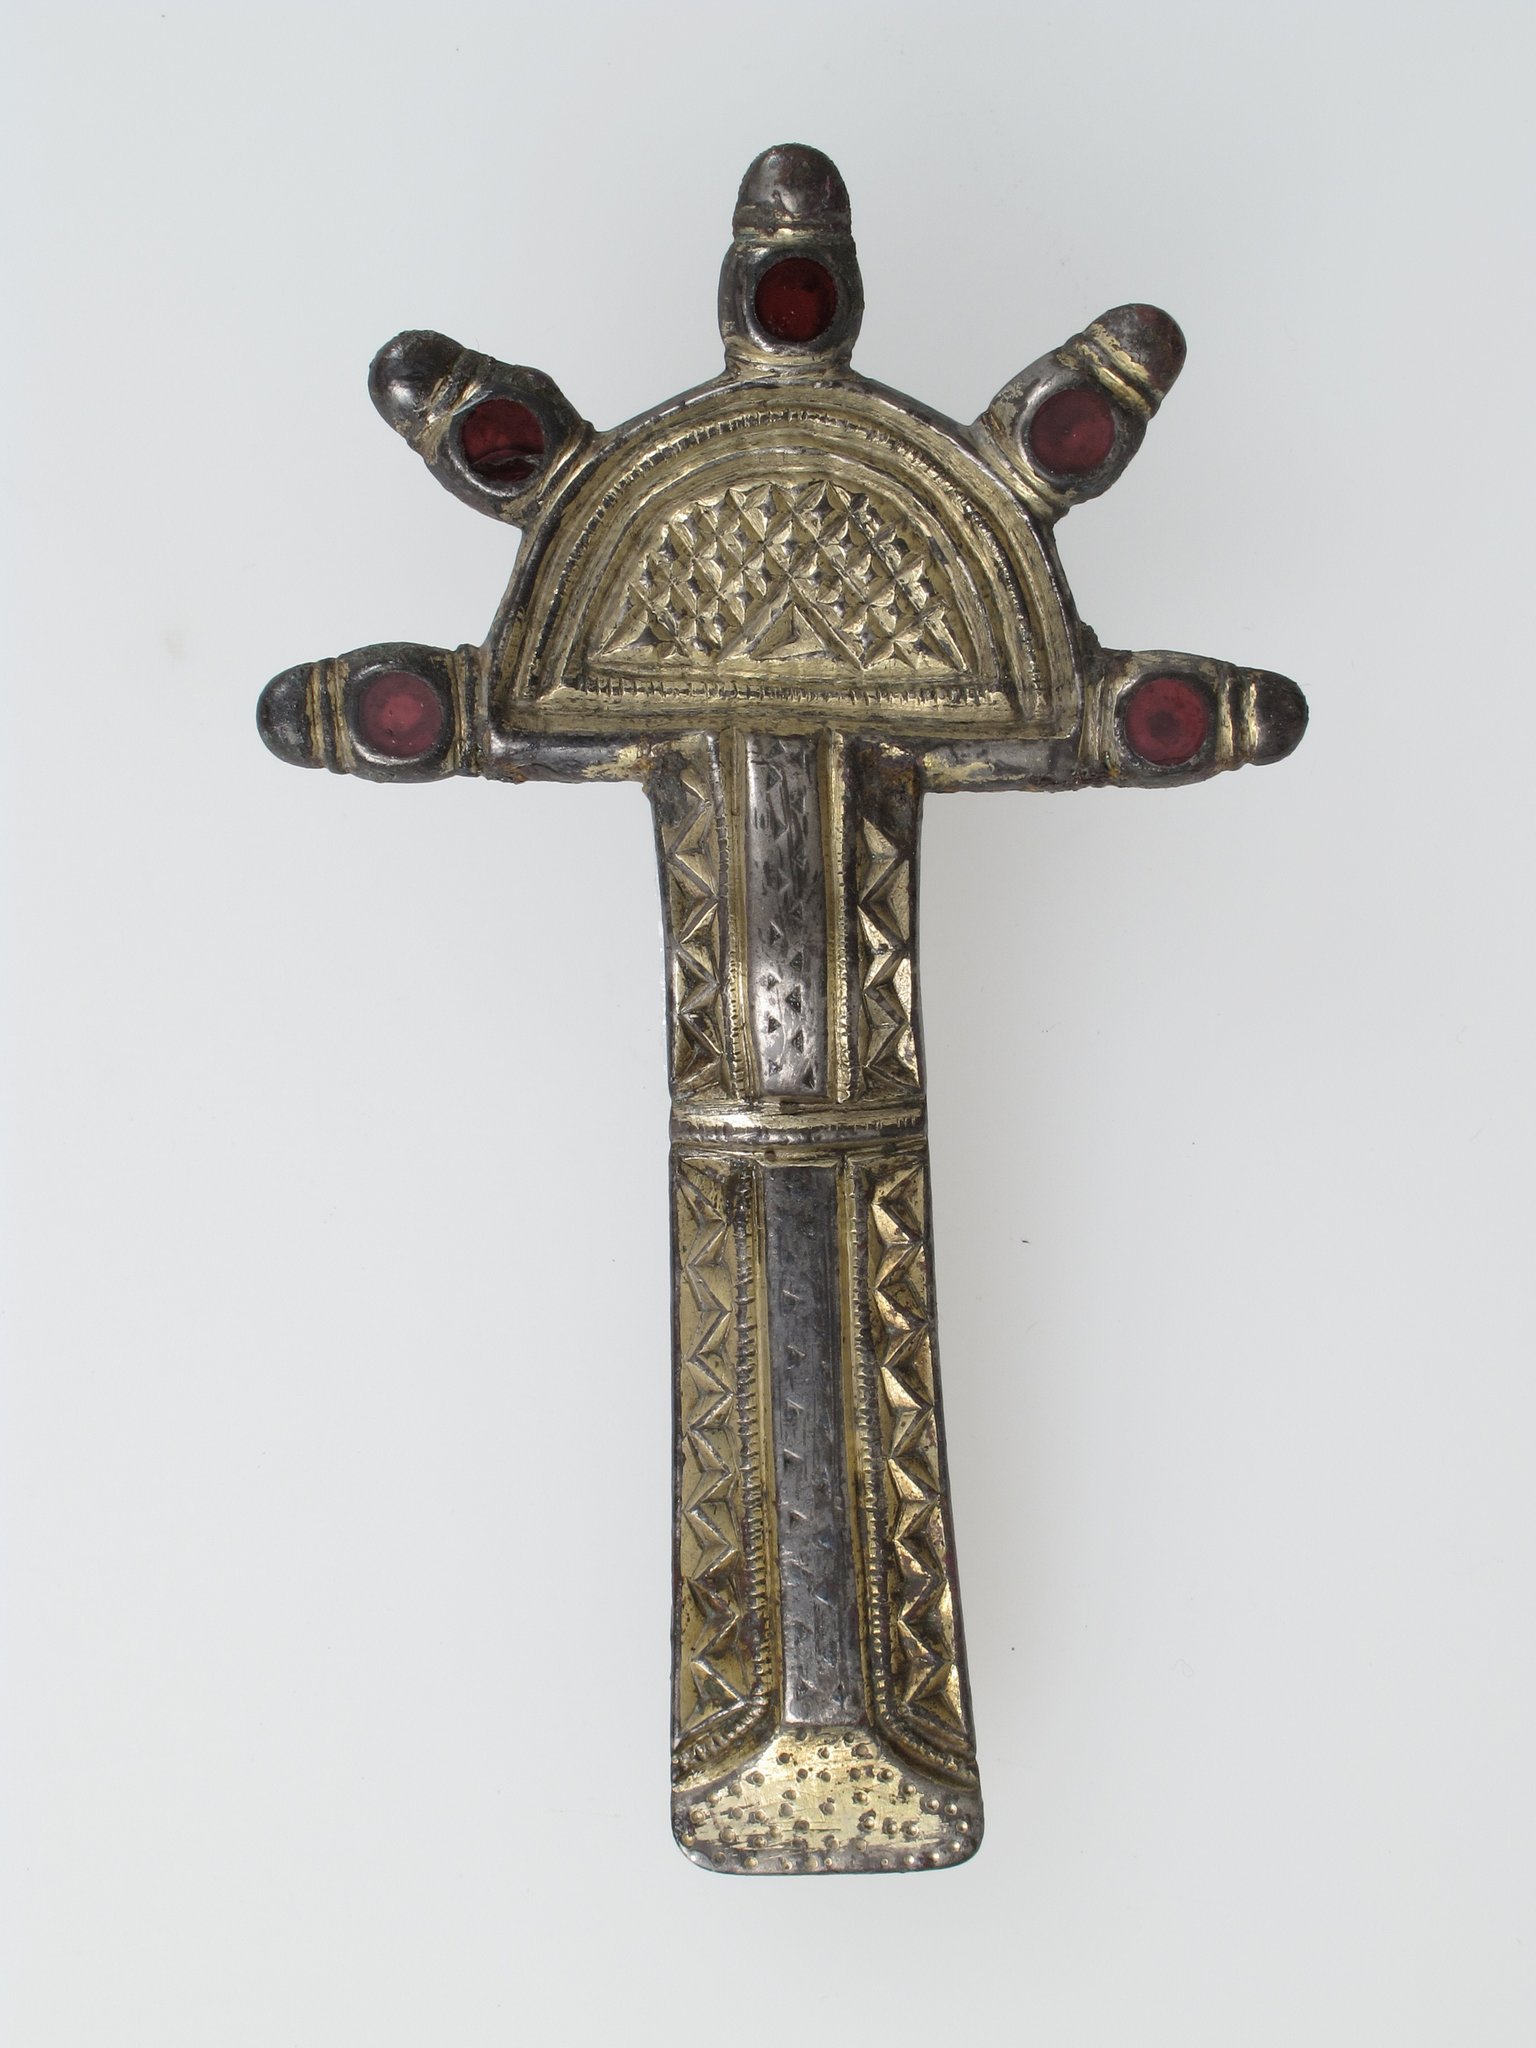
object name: brooch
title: Bow Brooch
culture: frankish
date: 534-566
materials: gemstone, iron, niello, silver gilt